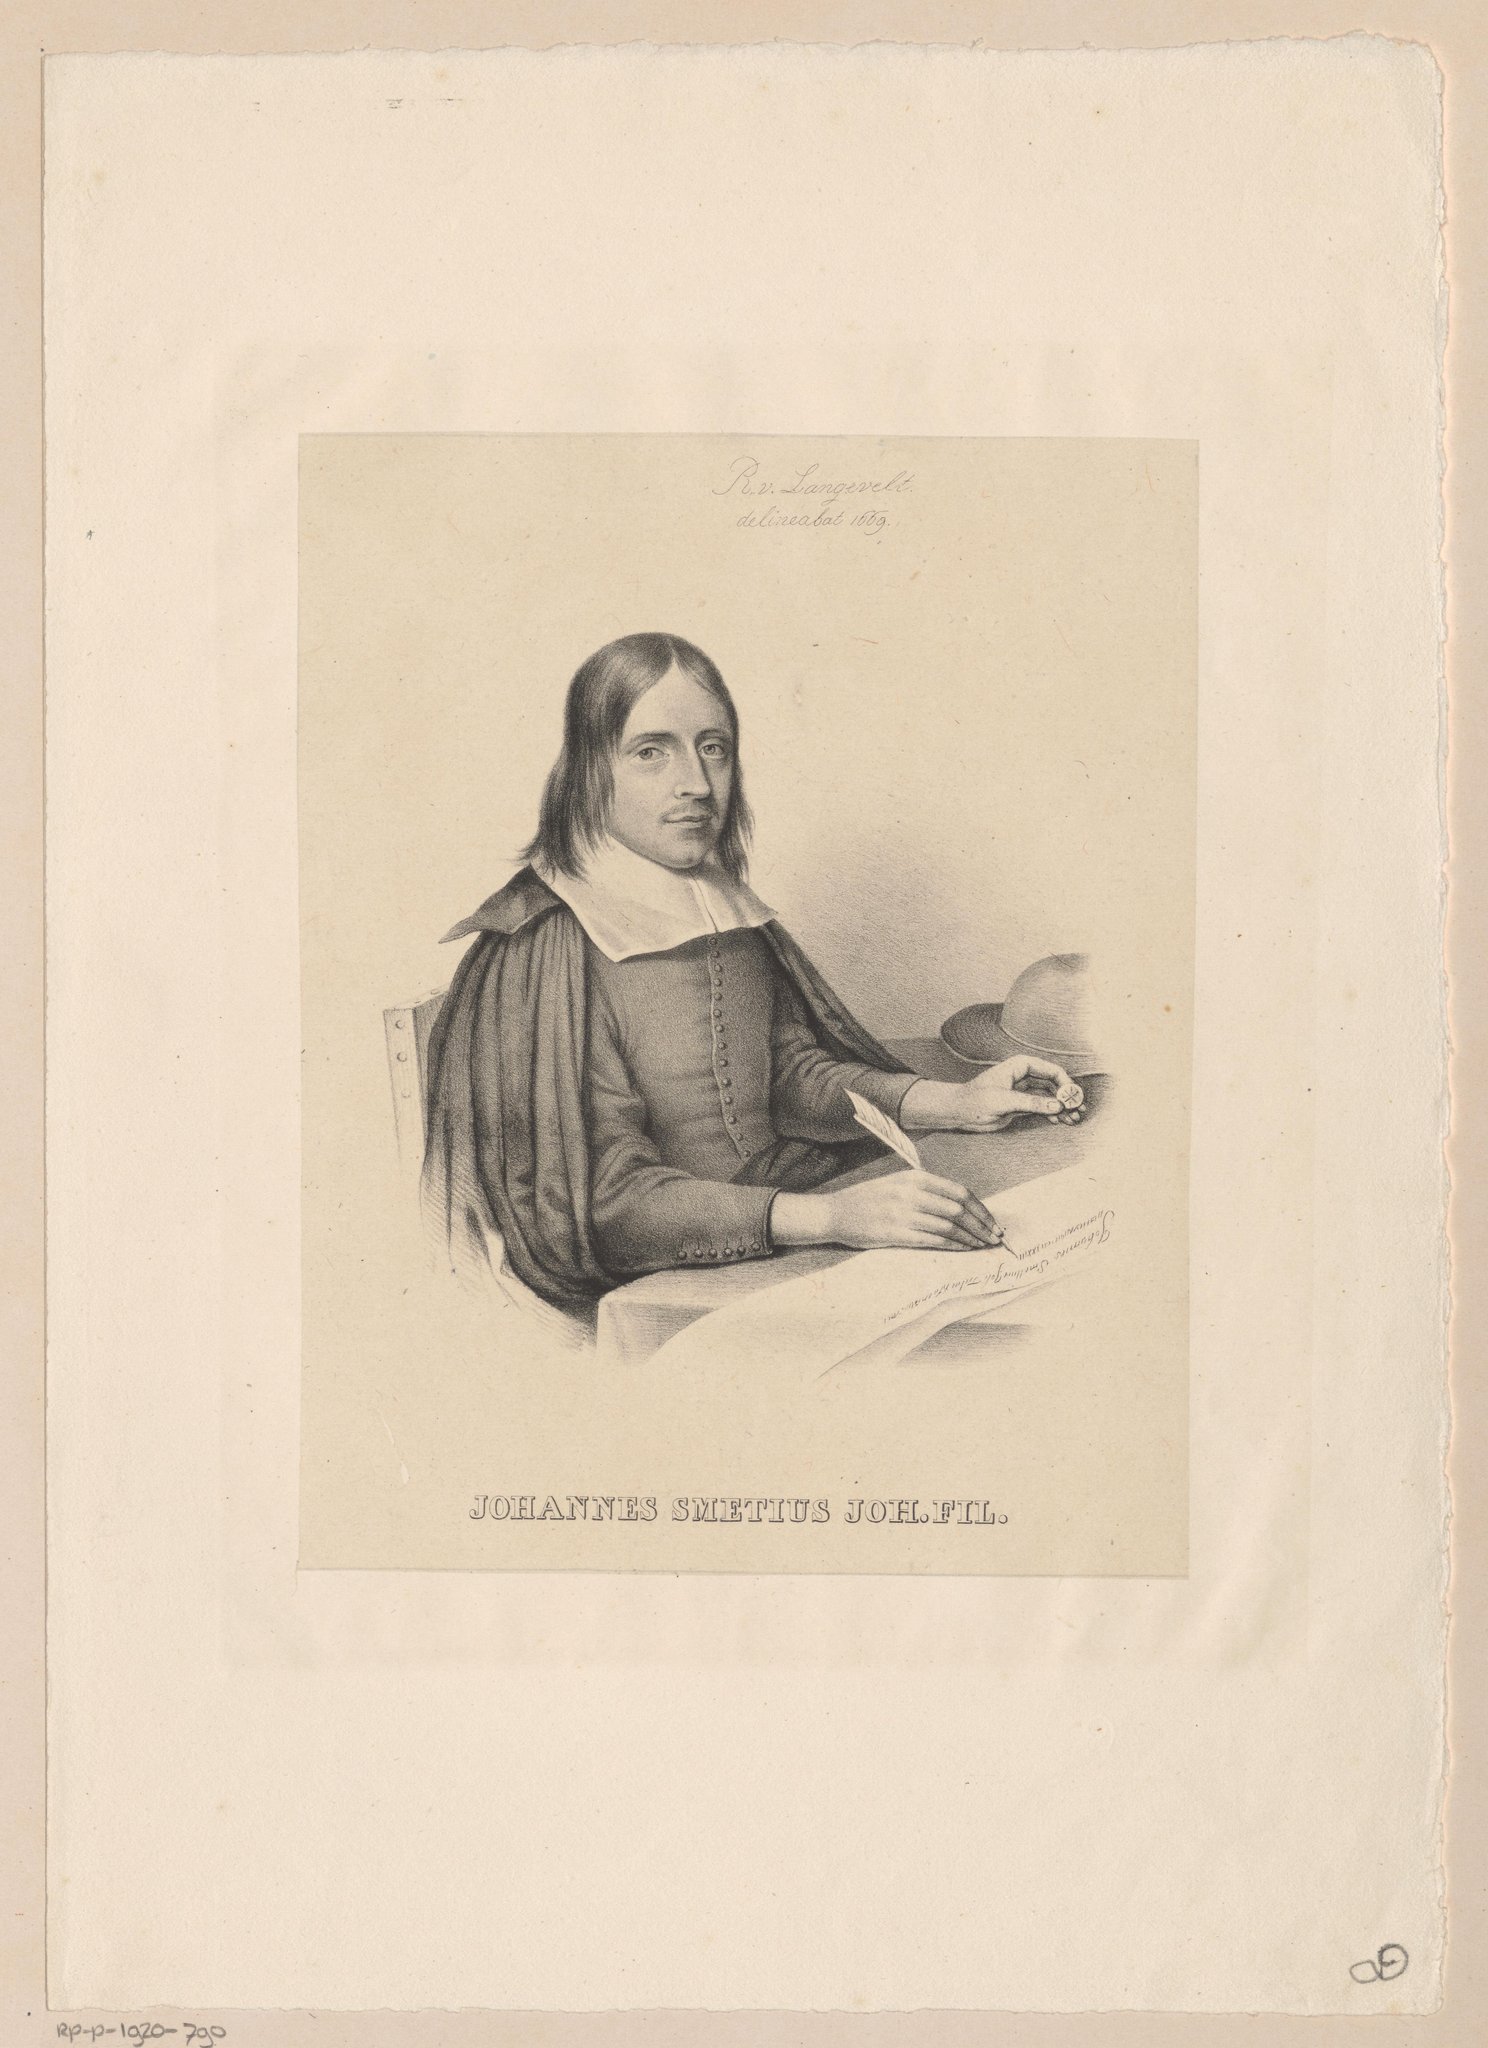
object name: print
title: Portret van Johannes Smetius jr.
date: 1809-1899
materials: paper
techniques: lithograph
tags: nijmegen, historical persons, art collector, functionaries and dignitaries (with name) ~ episcopal protestant churches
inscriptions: collector's mark: Lugt 2228